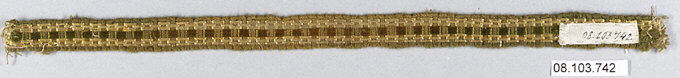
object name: gimp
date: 1801-1900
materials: wool